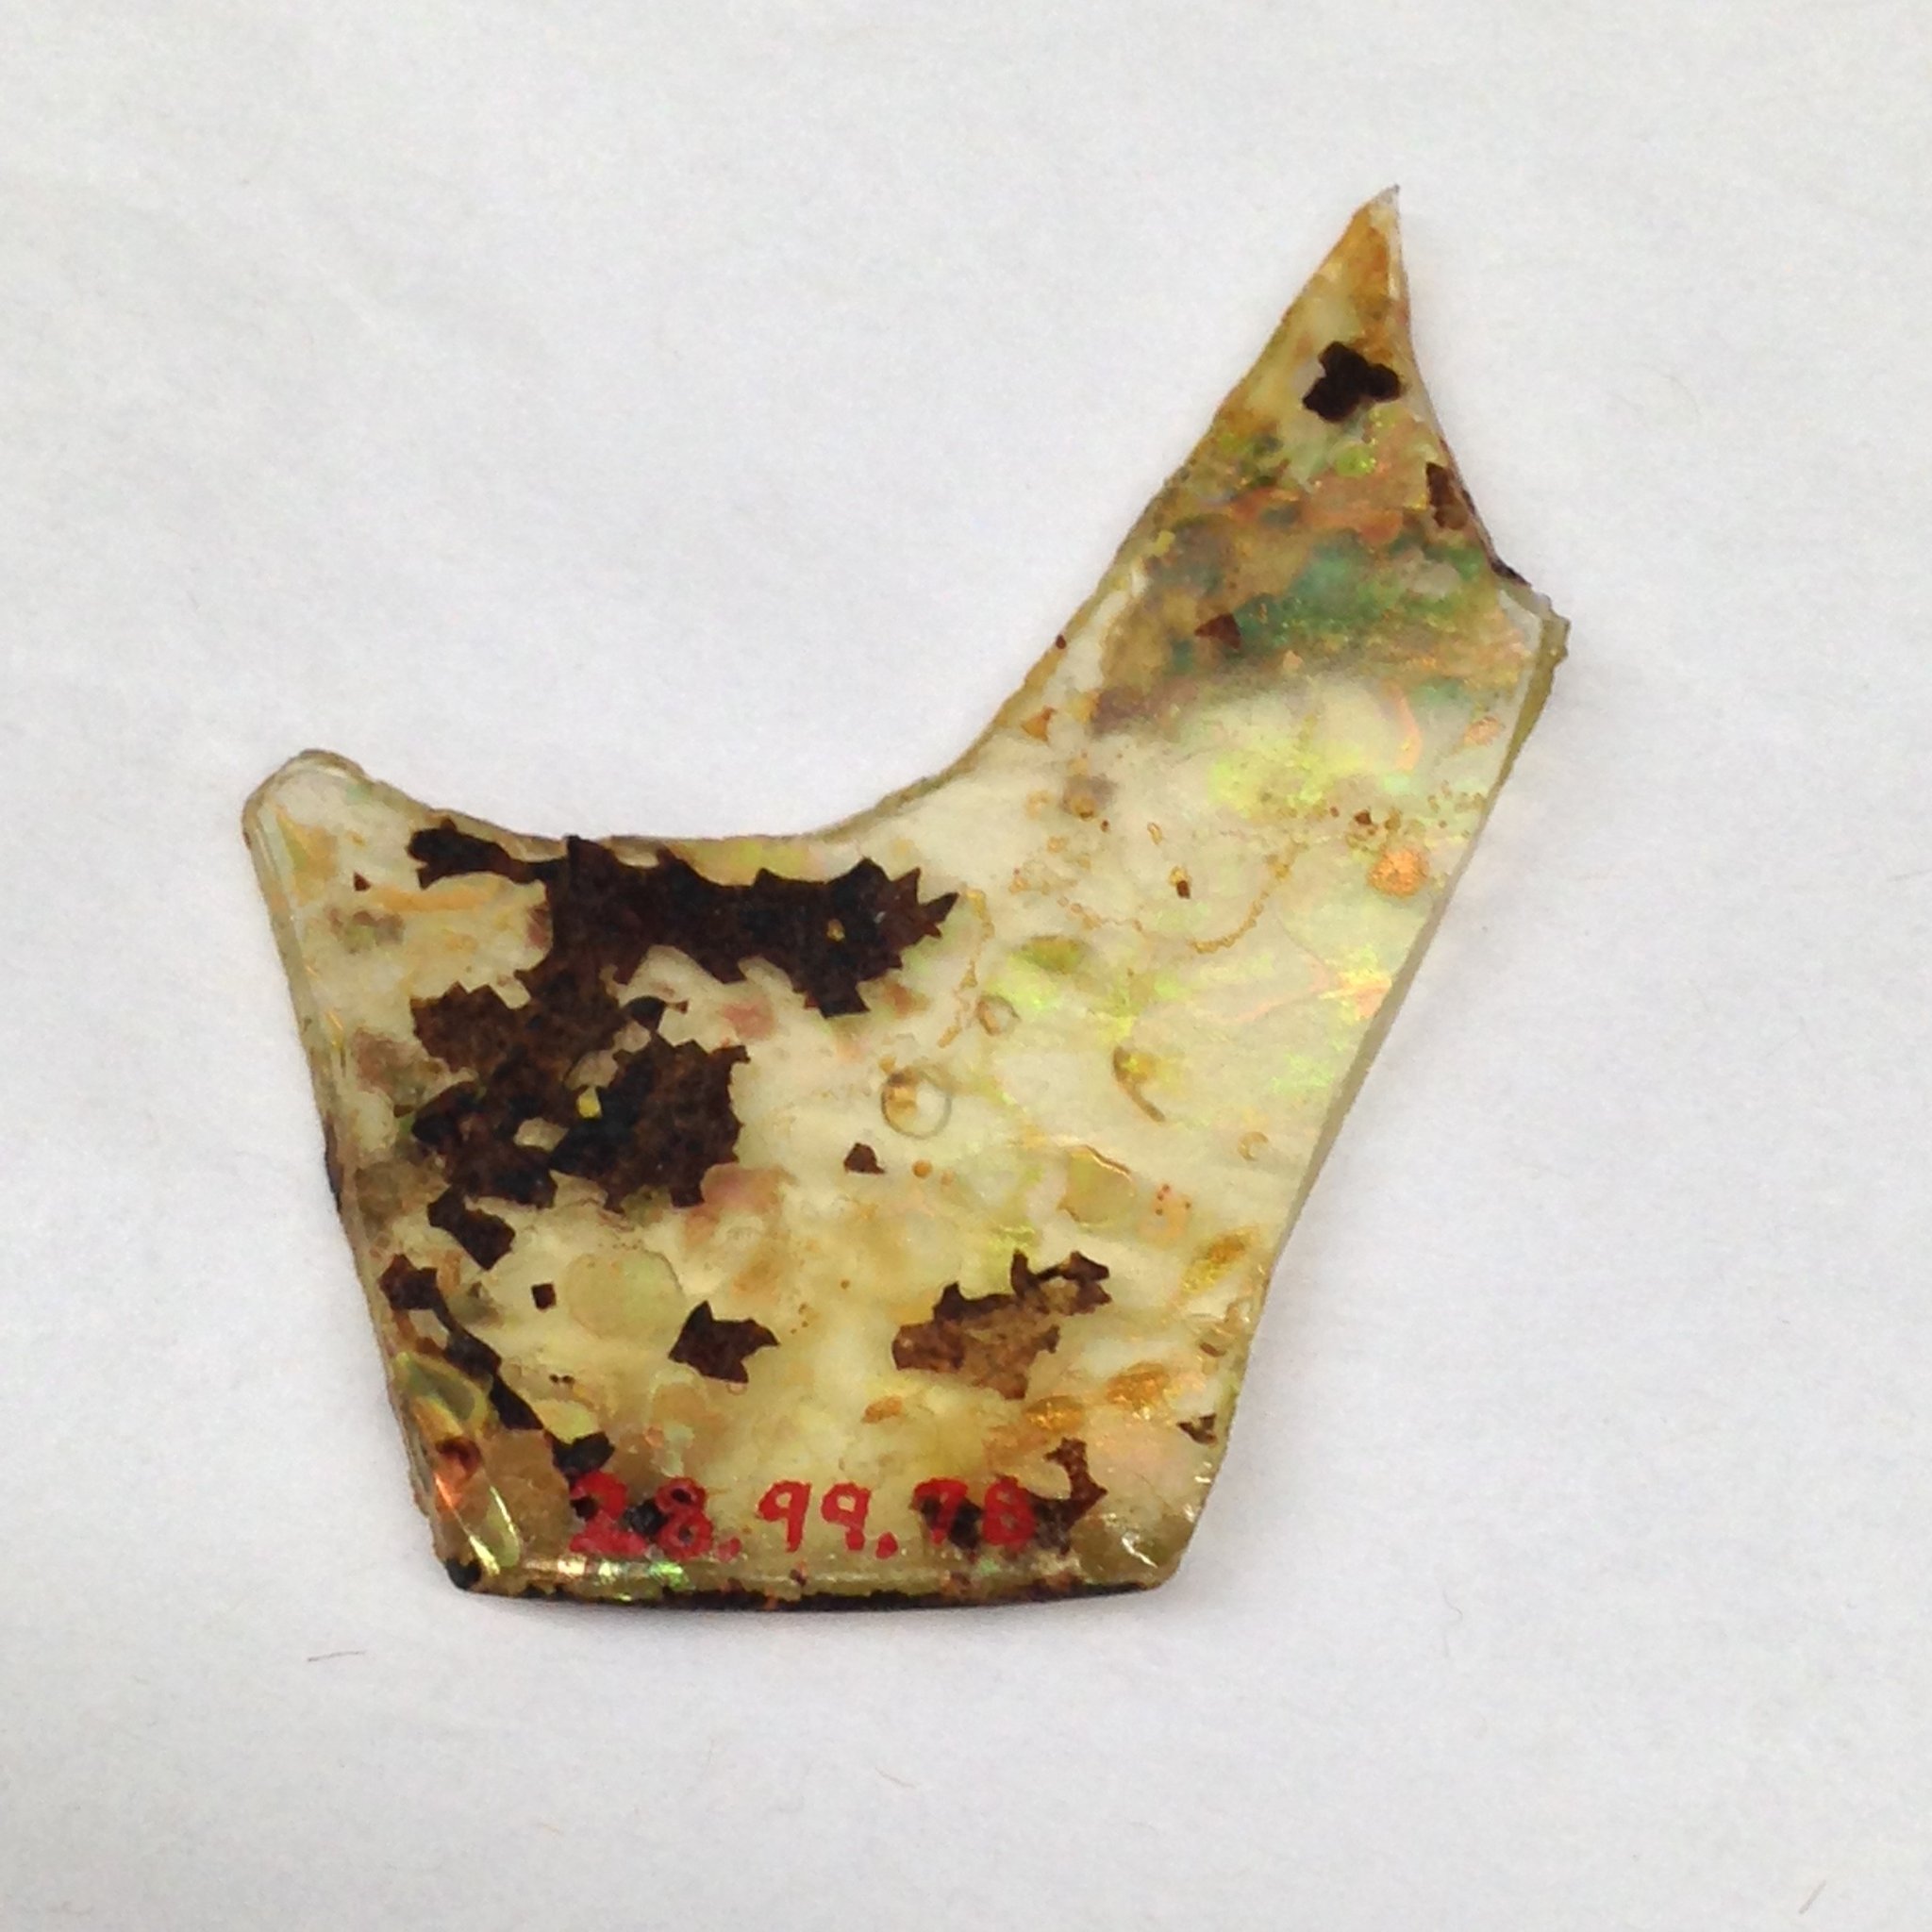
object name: fragment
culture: european or middle eastern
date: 1150-1250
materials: ceramic, glass